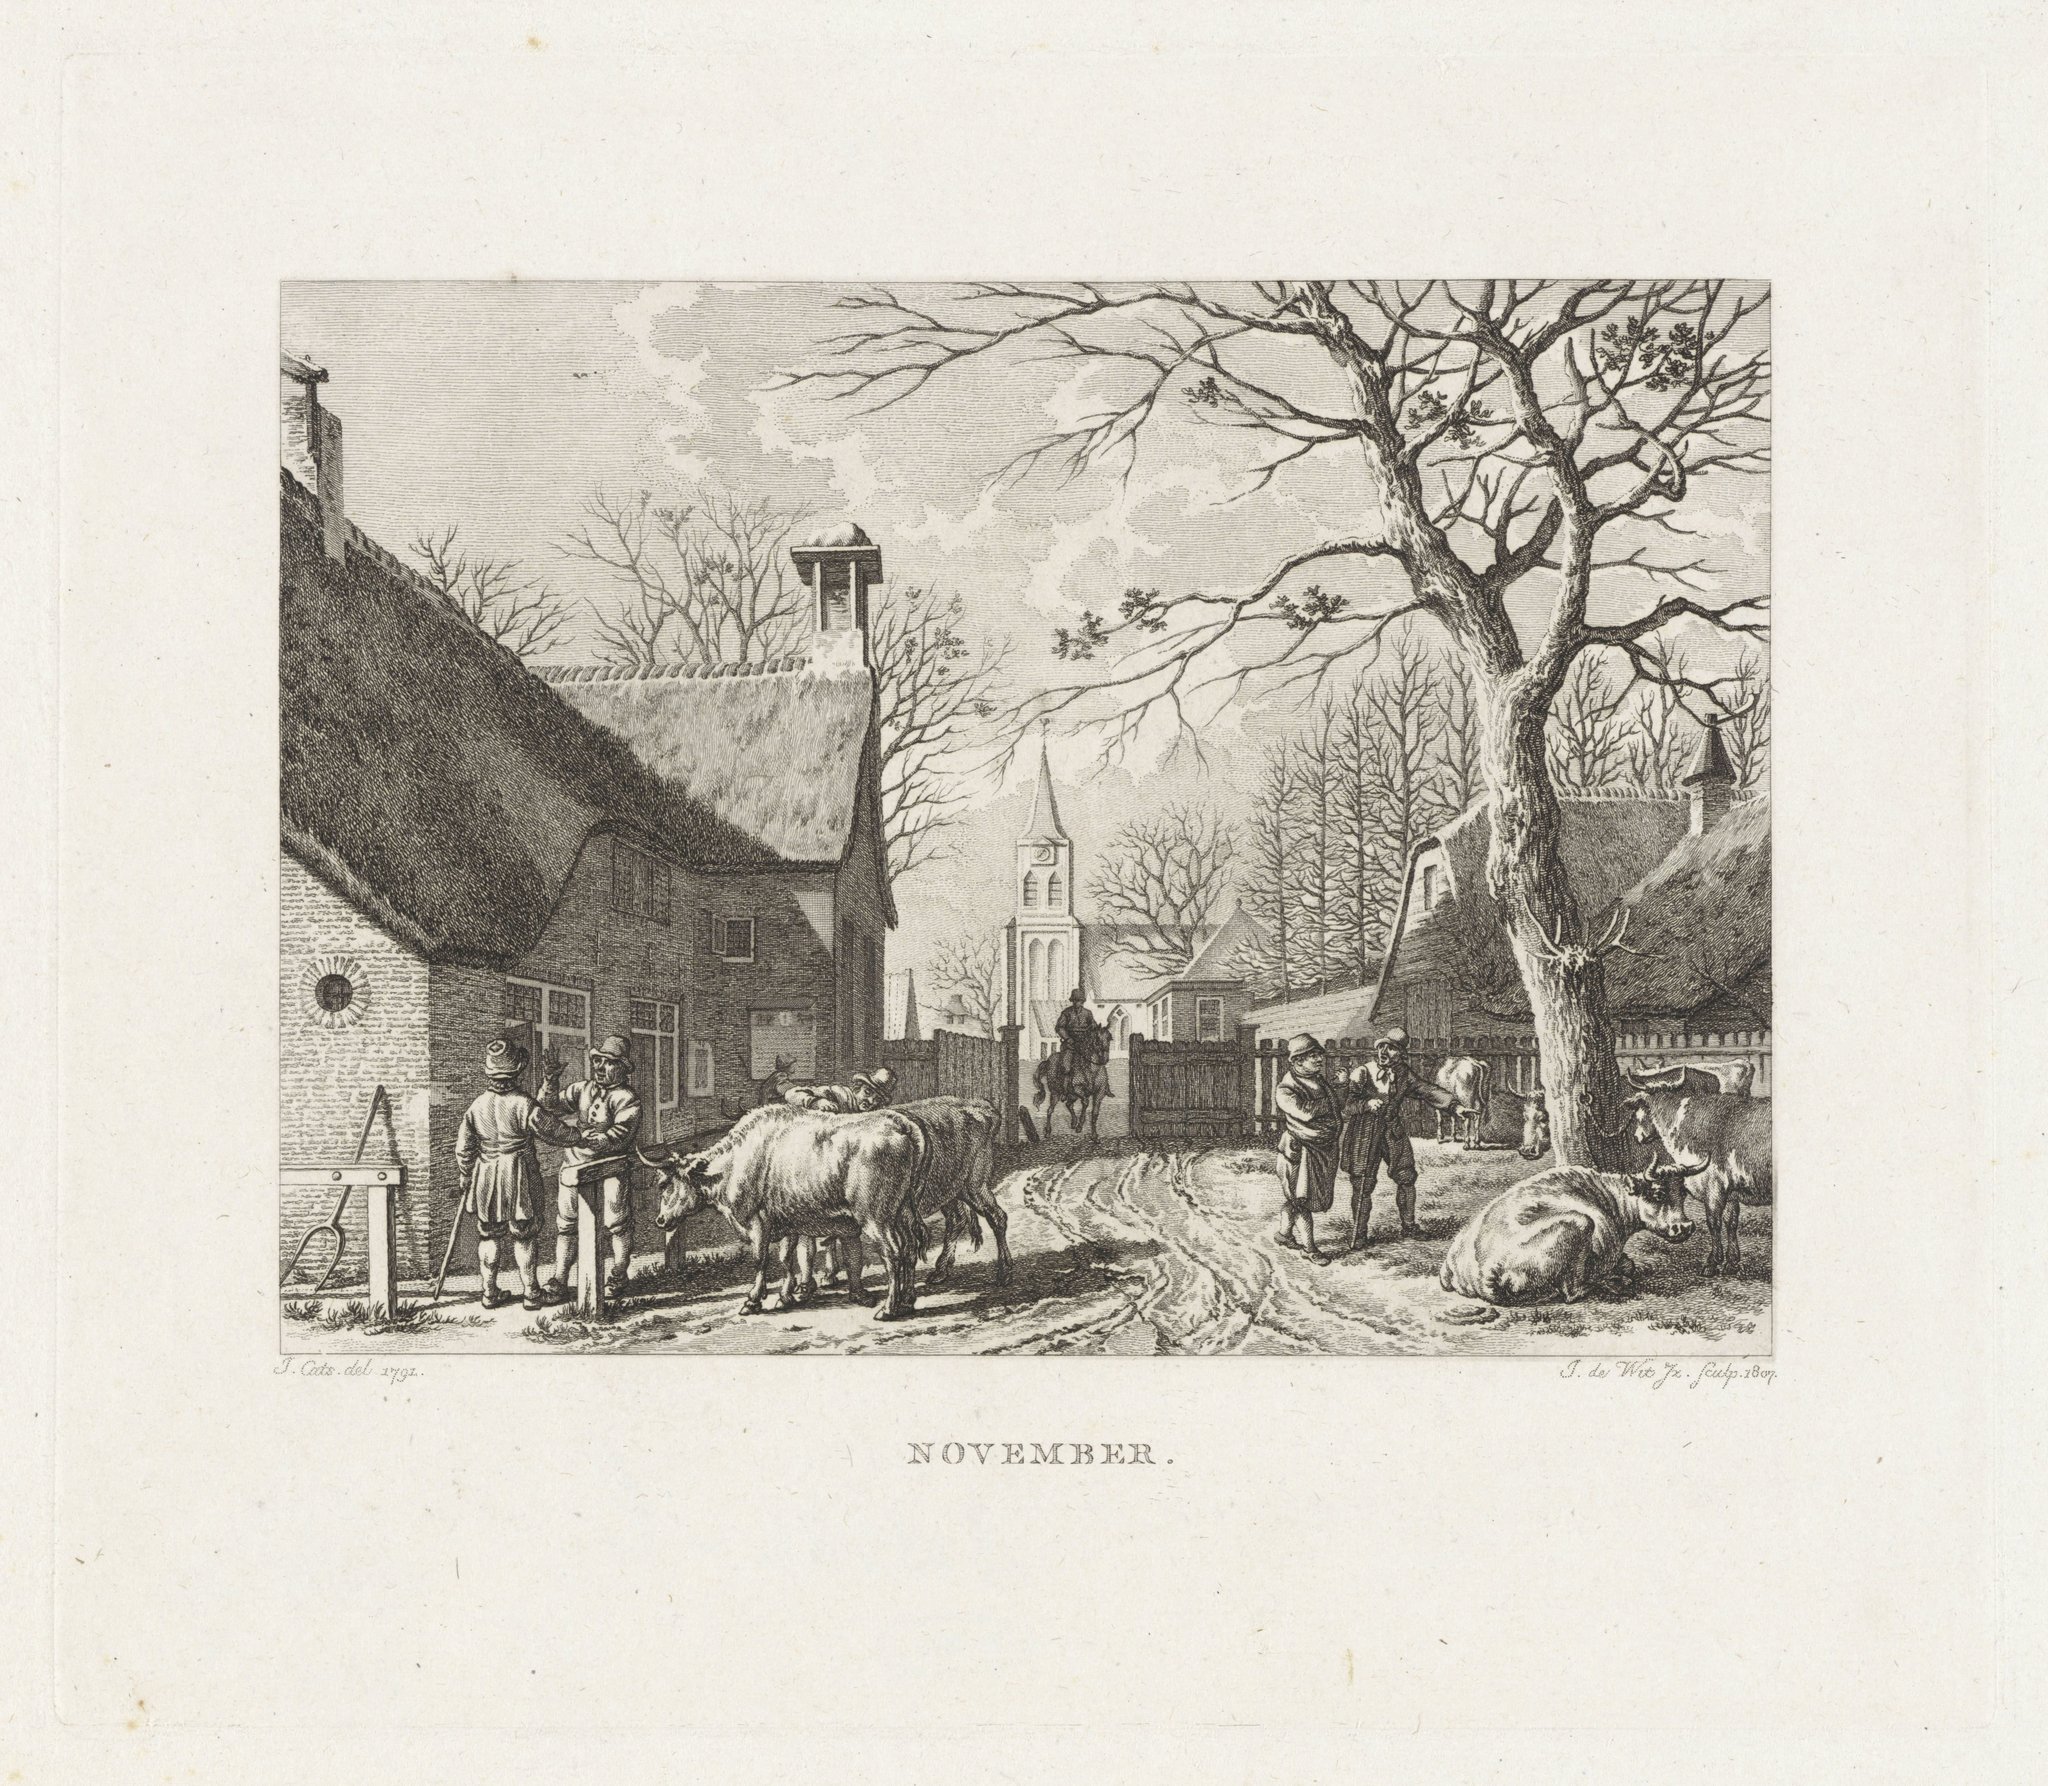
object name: print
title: De twaalf maanden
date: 1807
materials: paper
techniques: etching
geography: haarlem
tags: november and its 'labours' (+ with scenes showing human occupations ~ seasons and months), public road in village, market, bovine cattle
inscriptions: collector's mark: Lugt 2228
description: Gezicht in een dorp met op de voorgrond onderhandelende boeren bij ossen. Een kerk op de achtergrond.